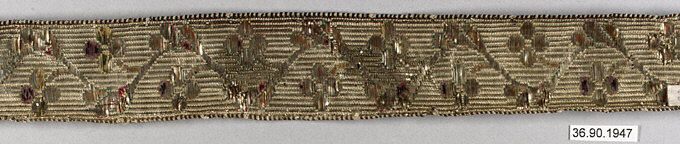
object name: galloon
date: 1701-1800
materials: silk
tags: flowers